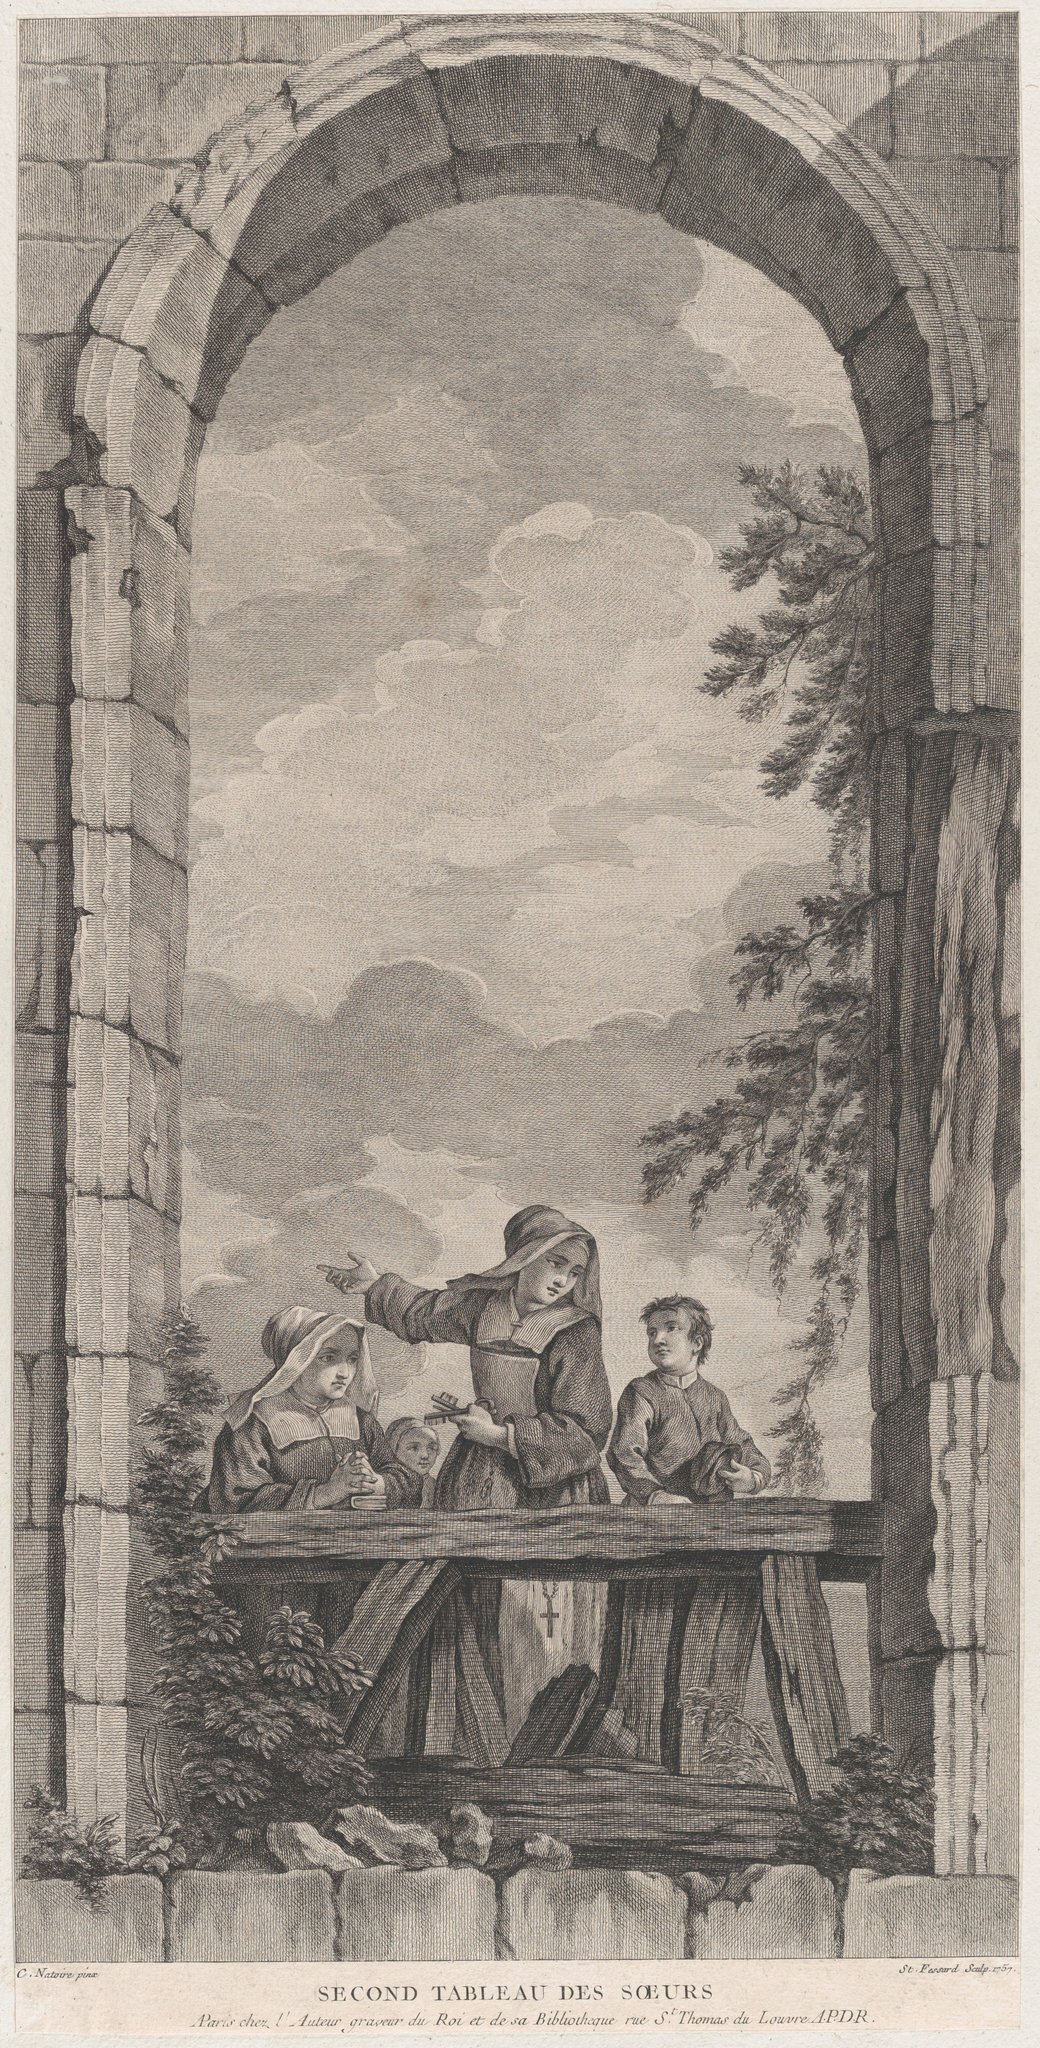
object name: print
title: The Chapel of the Enfants-Trouvés in Paris: Religieuses et garçonnets regardant la crèche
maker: etienne fessard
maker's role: artist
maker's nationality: french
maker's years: 1714-1777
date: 1757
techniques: engraving, etching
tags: boys,women